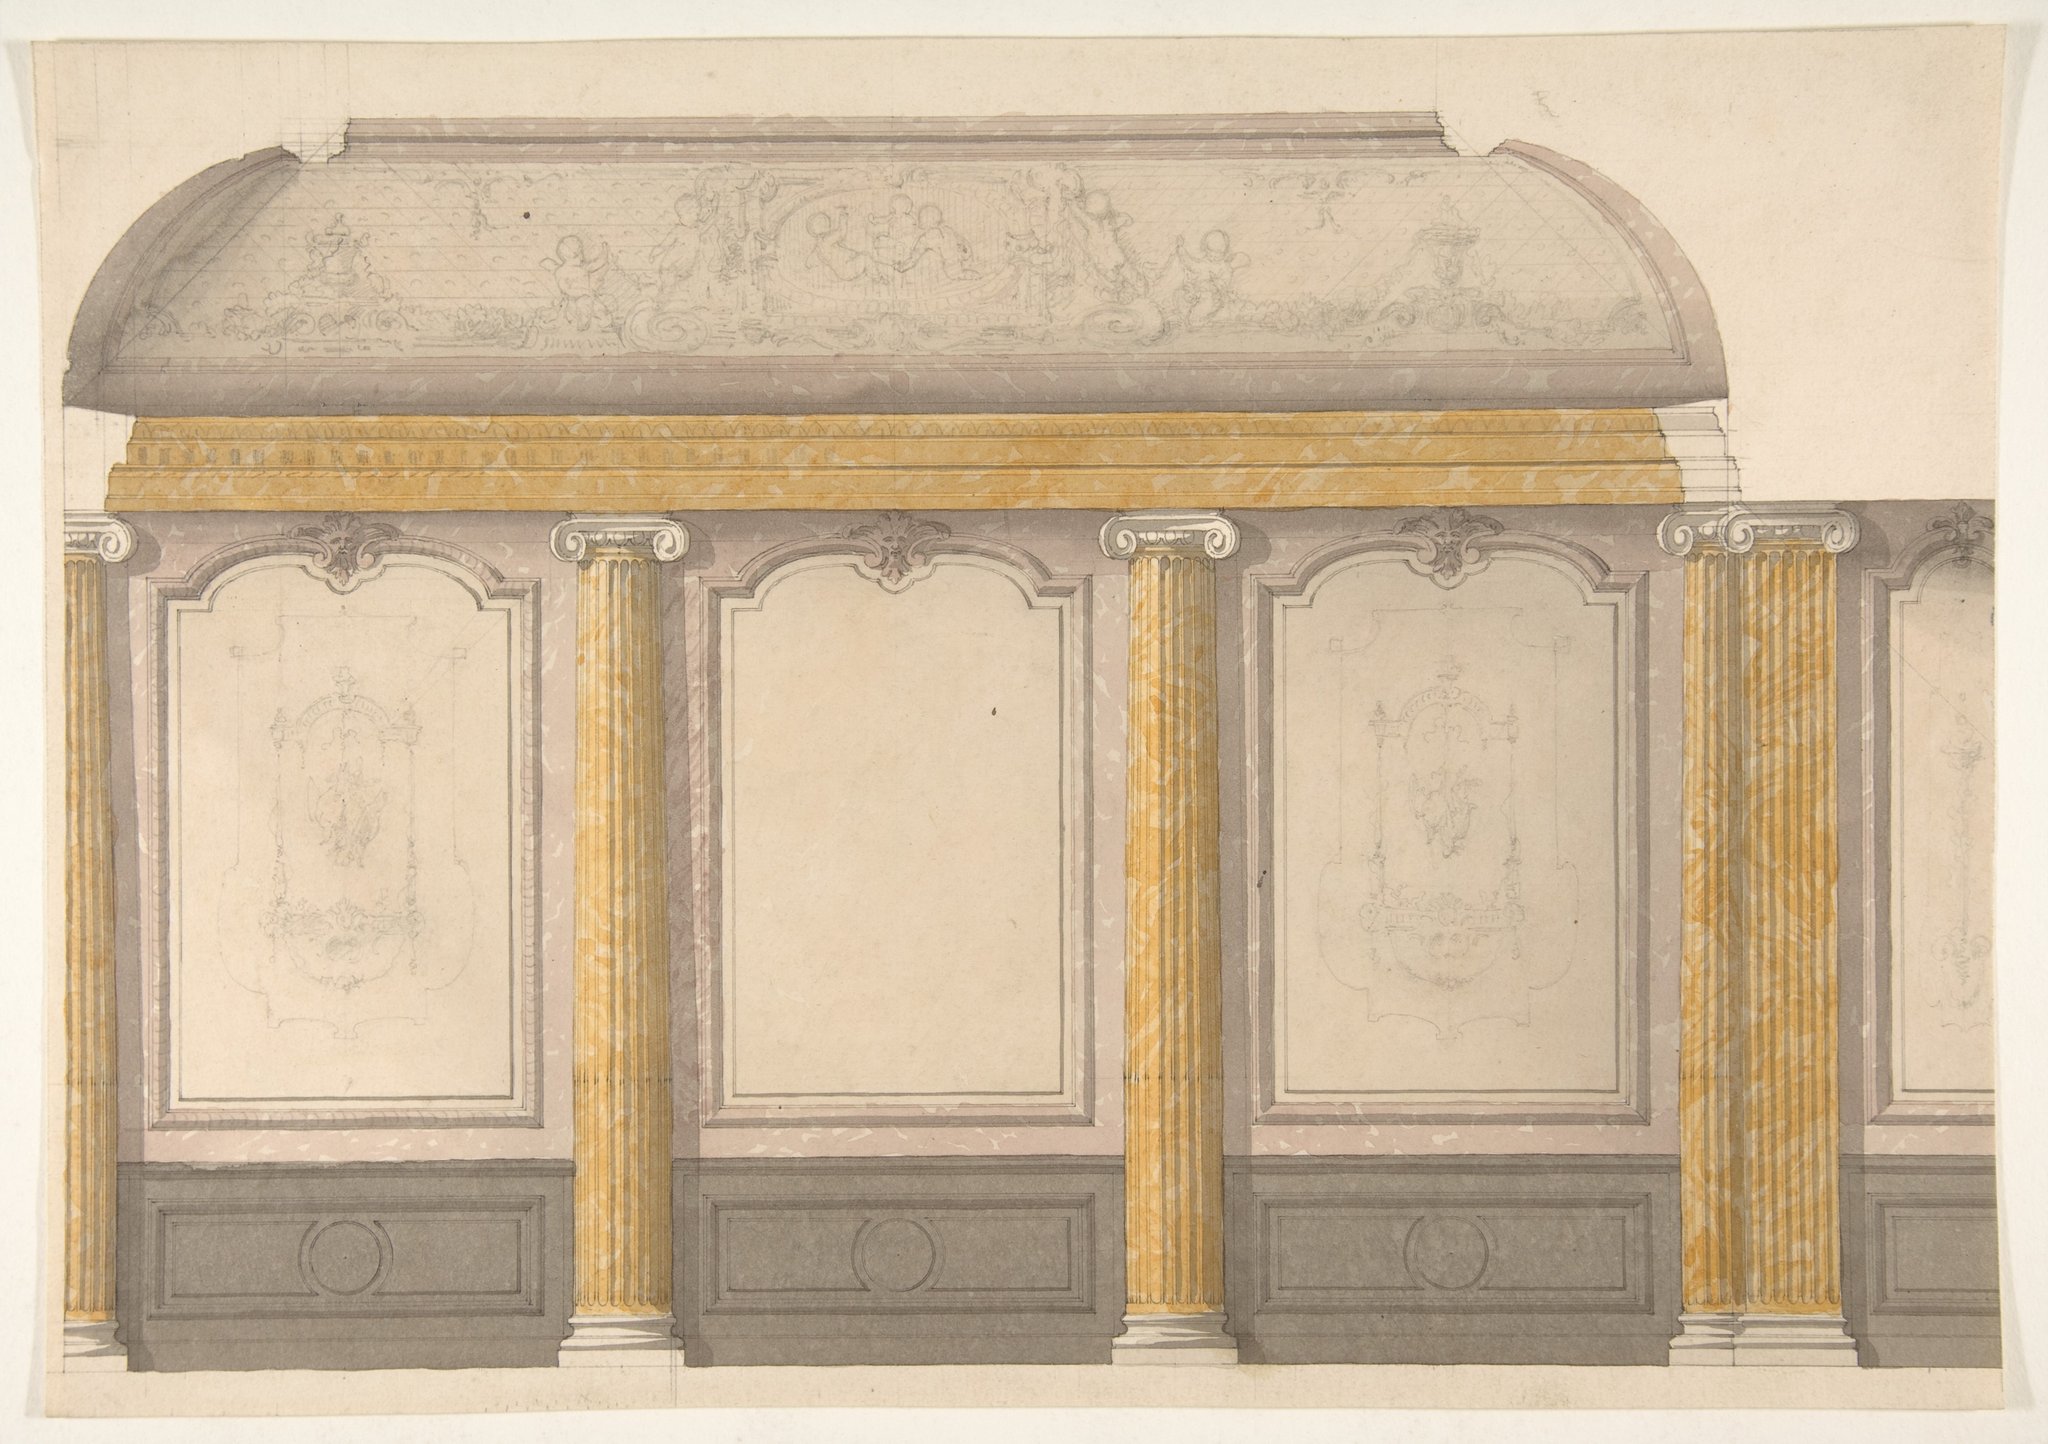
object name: drawing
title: Design for wall panels with putti and flowered garlands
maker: jules-edmond-charles lachaise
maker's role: artist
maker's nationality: french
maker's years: 1897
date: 1851-1900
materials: graphite, ink, watercolor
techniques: pen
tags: architecture,columns